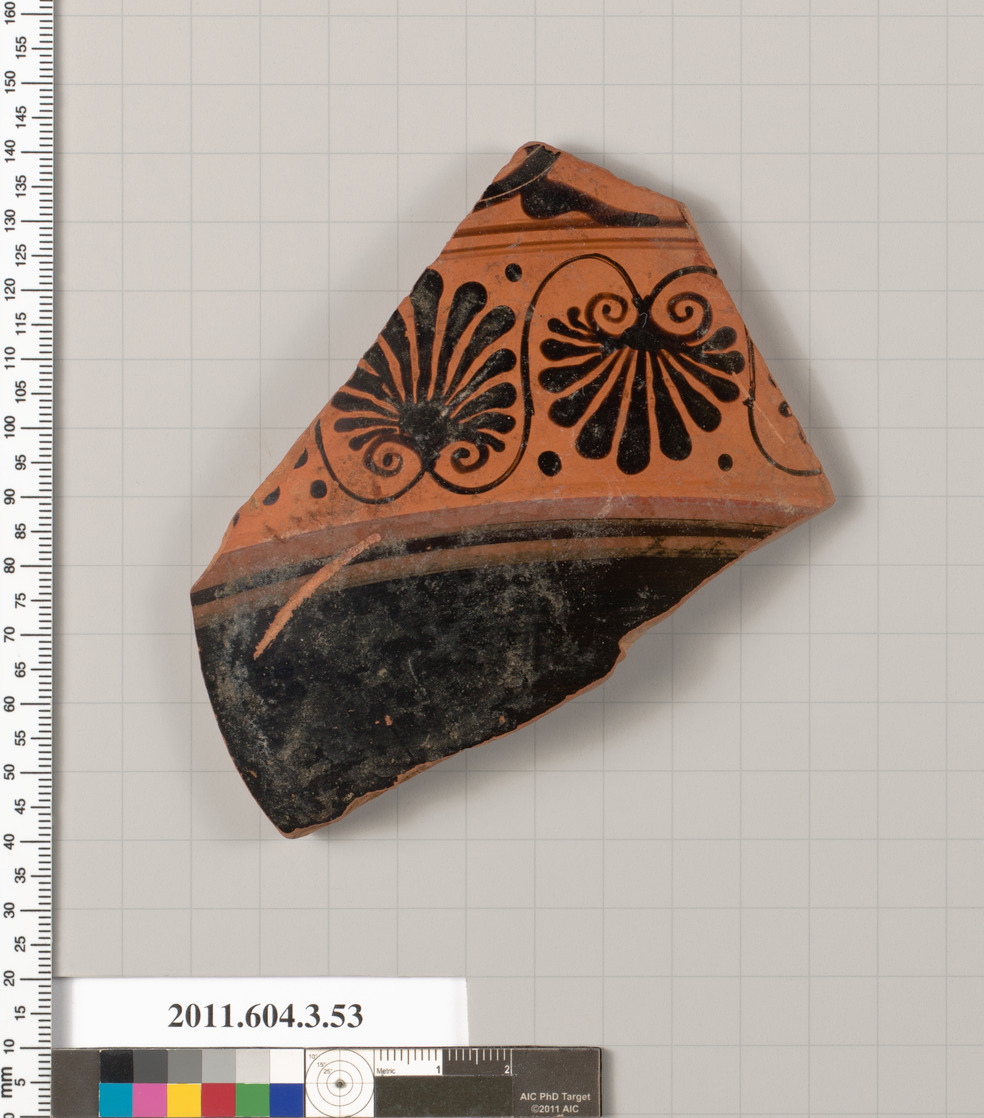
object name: hydria fragment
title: Terracotta fragment of a hydria (water jar)?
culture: greek, attic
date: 510-500 BCE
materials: terracotta